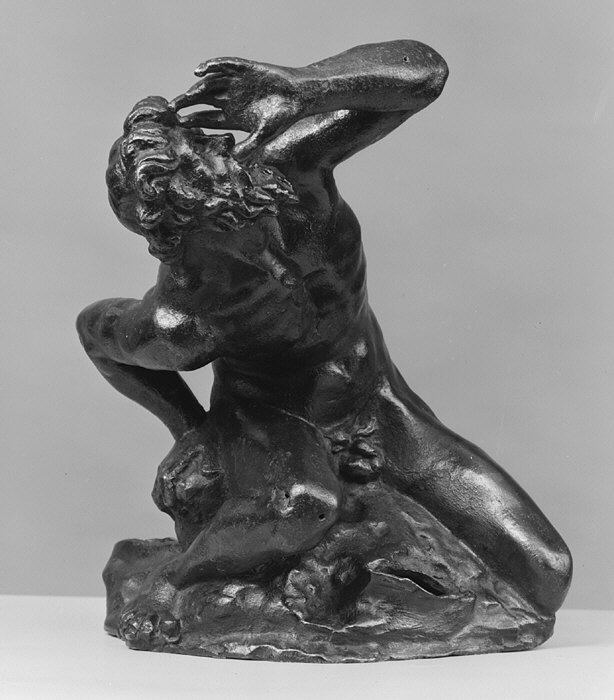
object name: statuette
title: Old Sabine Crouching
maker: giambologna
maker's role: artist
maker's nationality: netherlandish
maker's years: 1529-1608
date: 1601-1800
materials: bronze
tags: male nudes